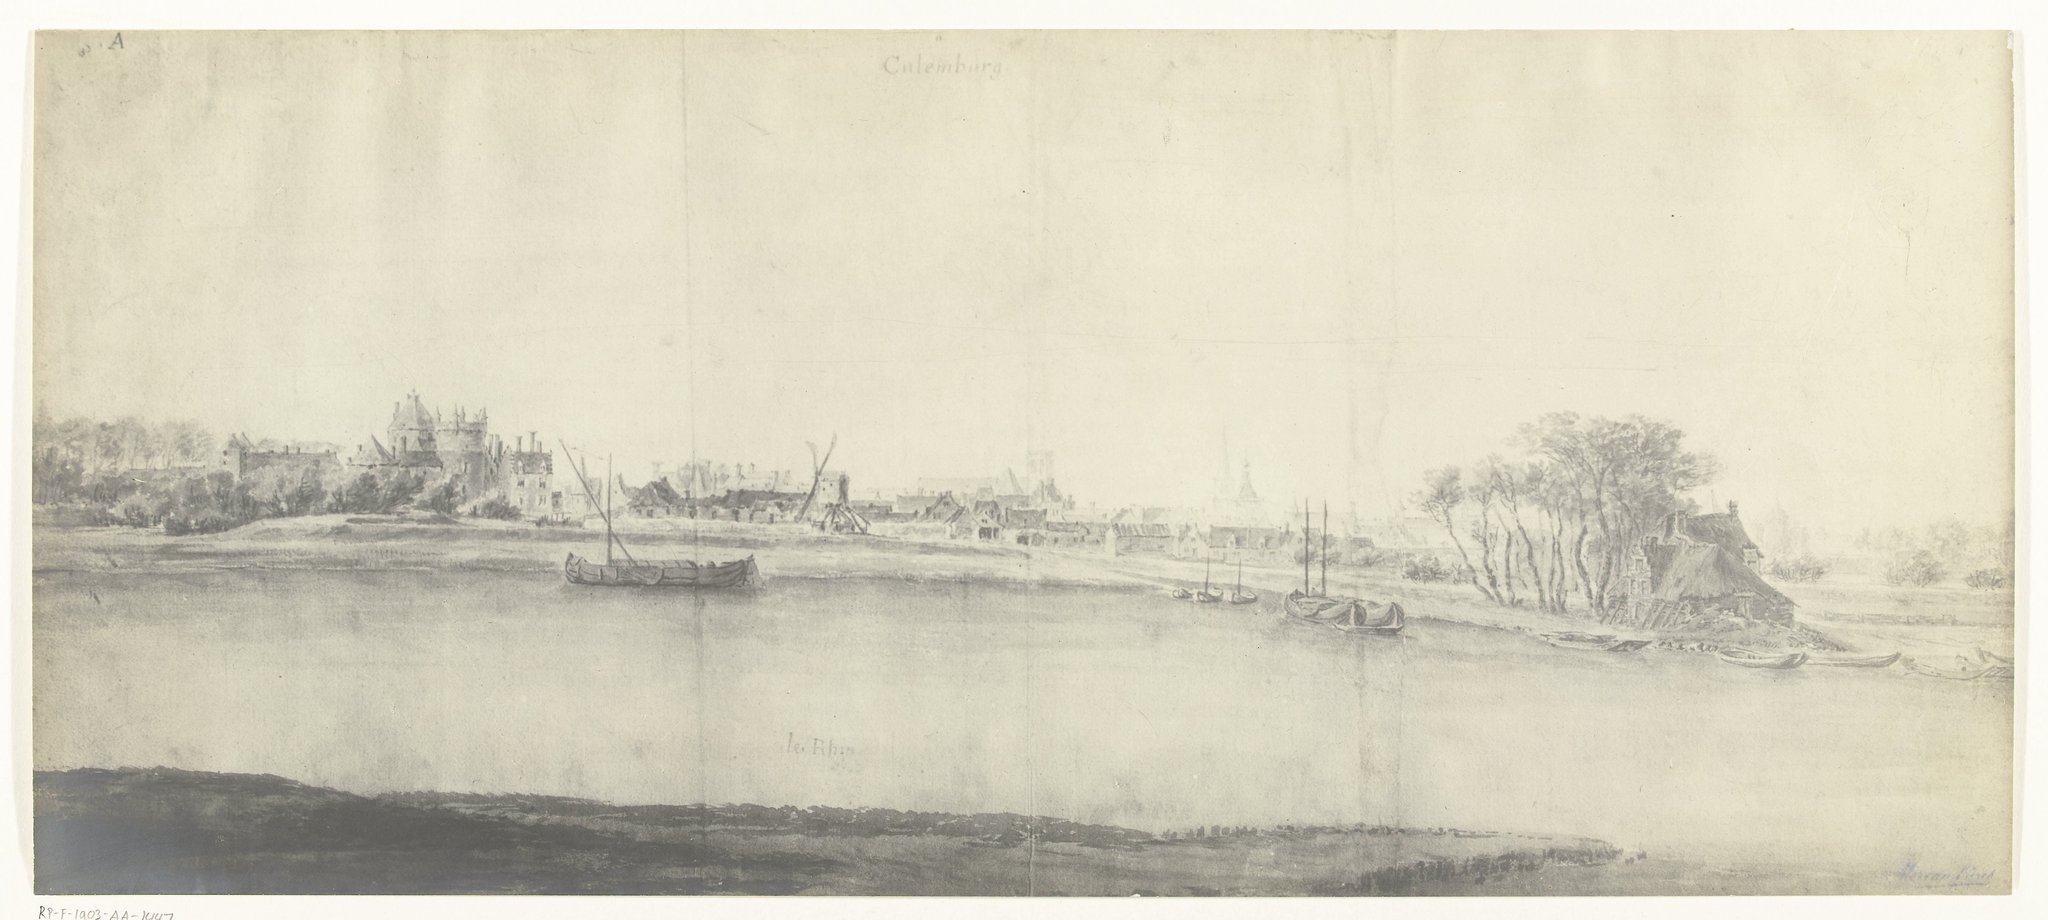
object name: photograph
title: Gezicht op Culemborg, 1672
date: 1900-1903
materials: paper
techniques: gelatin silver print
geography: france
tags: lodewijk xiv (koning van frankrijk), prospect of city, town panorama, silhouette of city, rampjaar (disaster year)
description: Niet in Frederik Muller; door het RPK toegevoegd nummer. Onderdeel van een groep van ca. 50 foto's van tekeningen van de Franse inval in de Nederlanden in 1672 door Adam Frans van der Meulen, bewaard in de Manufacture Nationale des Gobelins te Parijs.